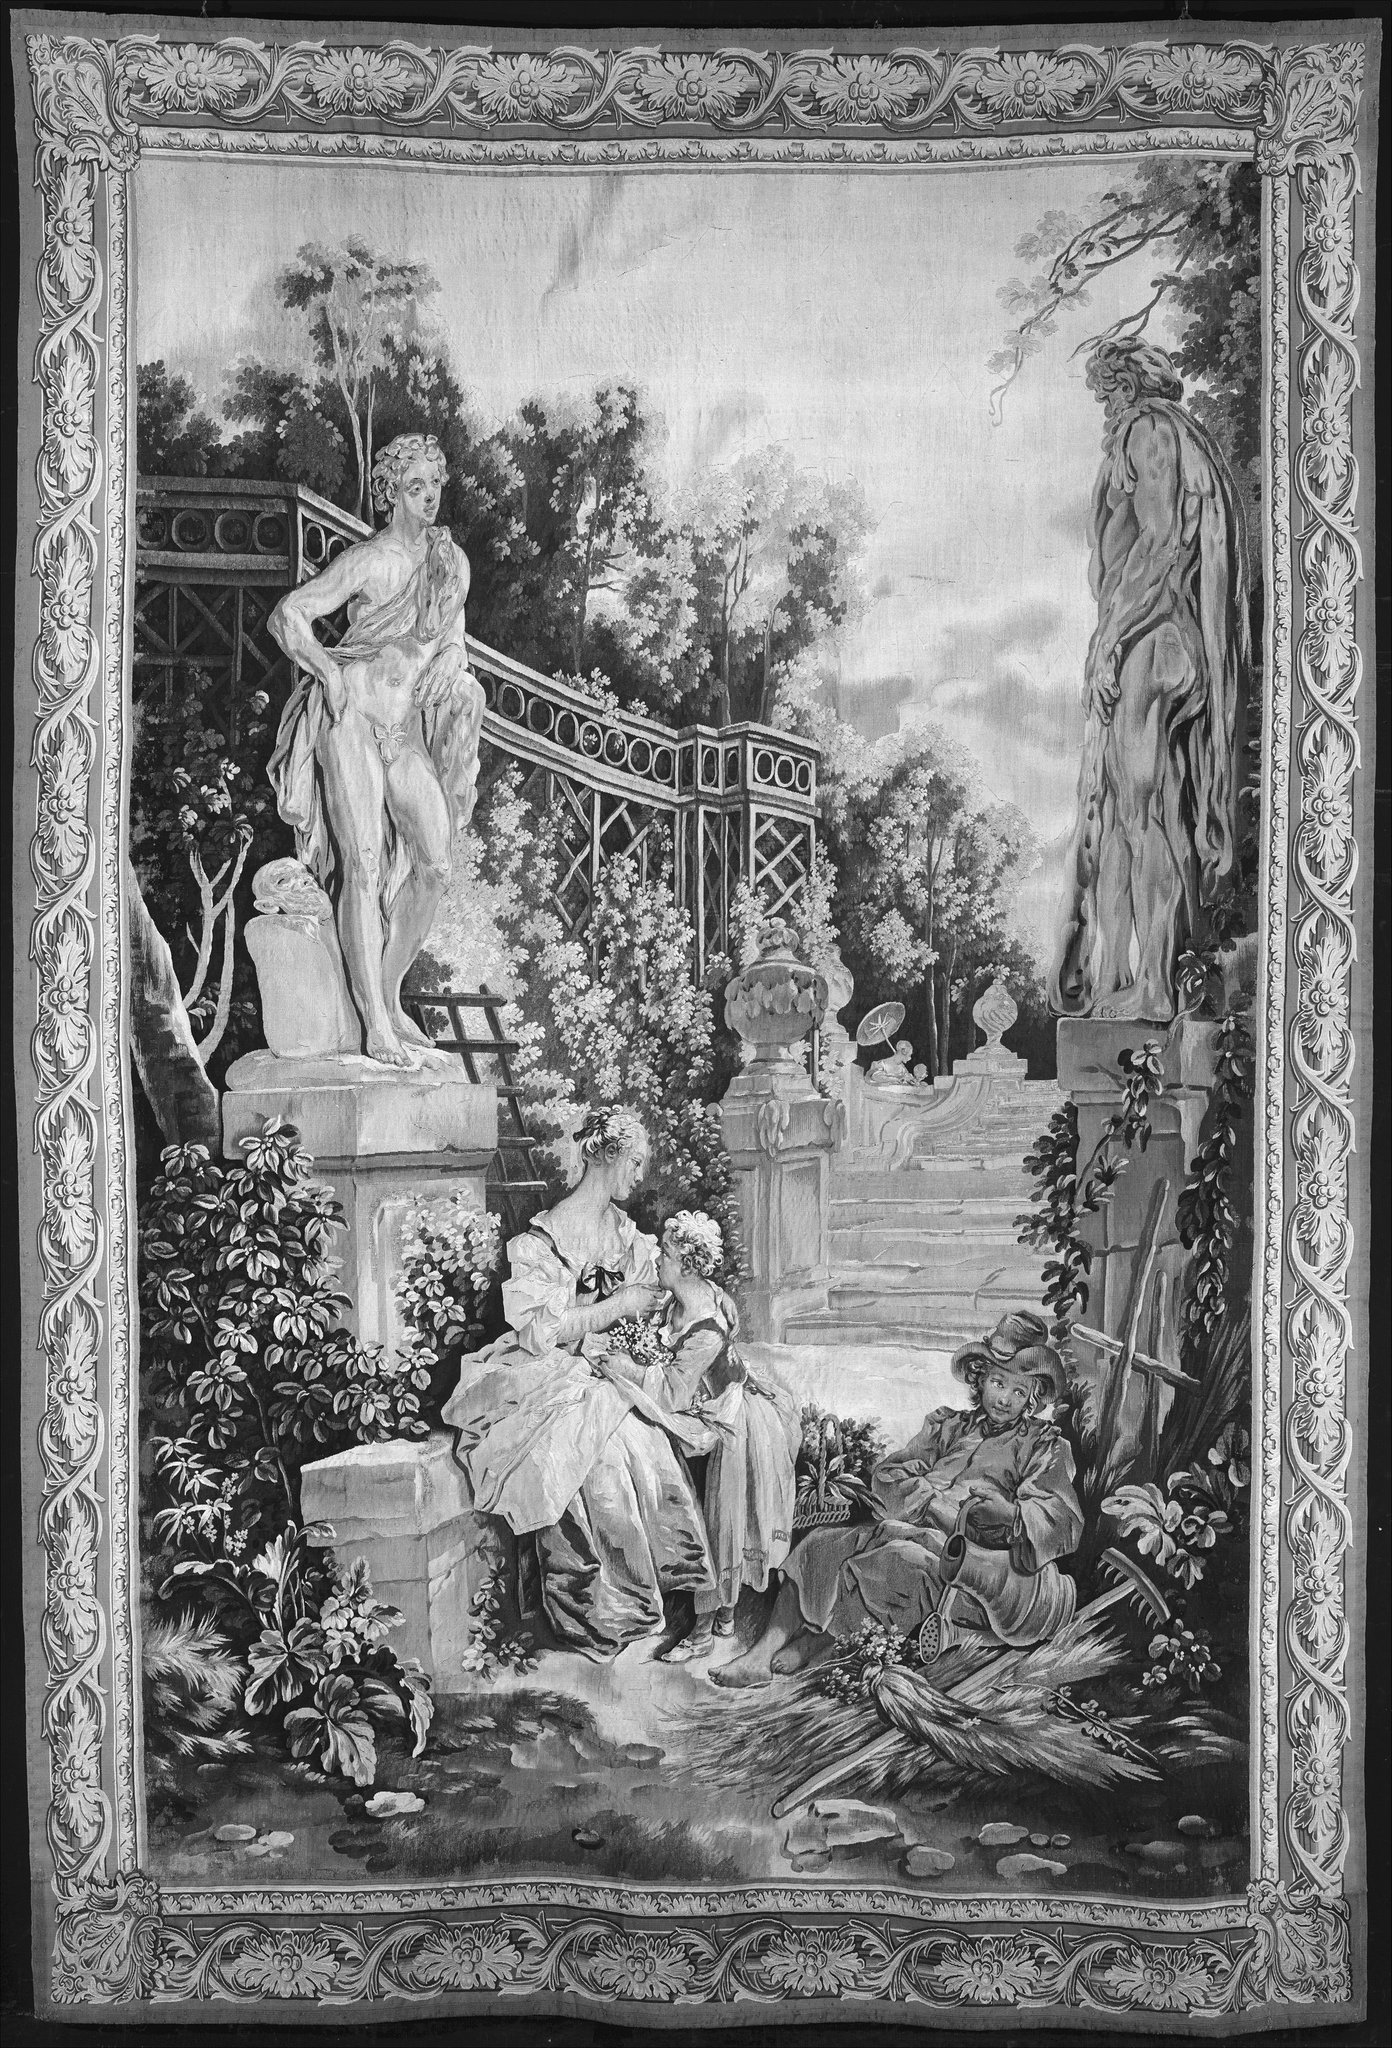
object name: tapestry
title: The Gardener from a set of the Italian Village Scenes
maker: françois boucher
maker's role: artist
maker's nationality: french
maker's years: 1703-1770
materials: silk, wool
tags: gardens,children,men,women,gardeners